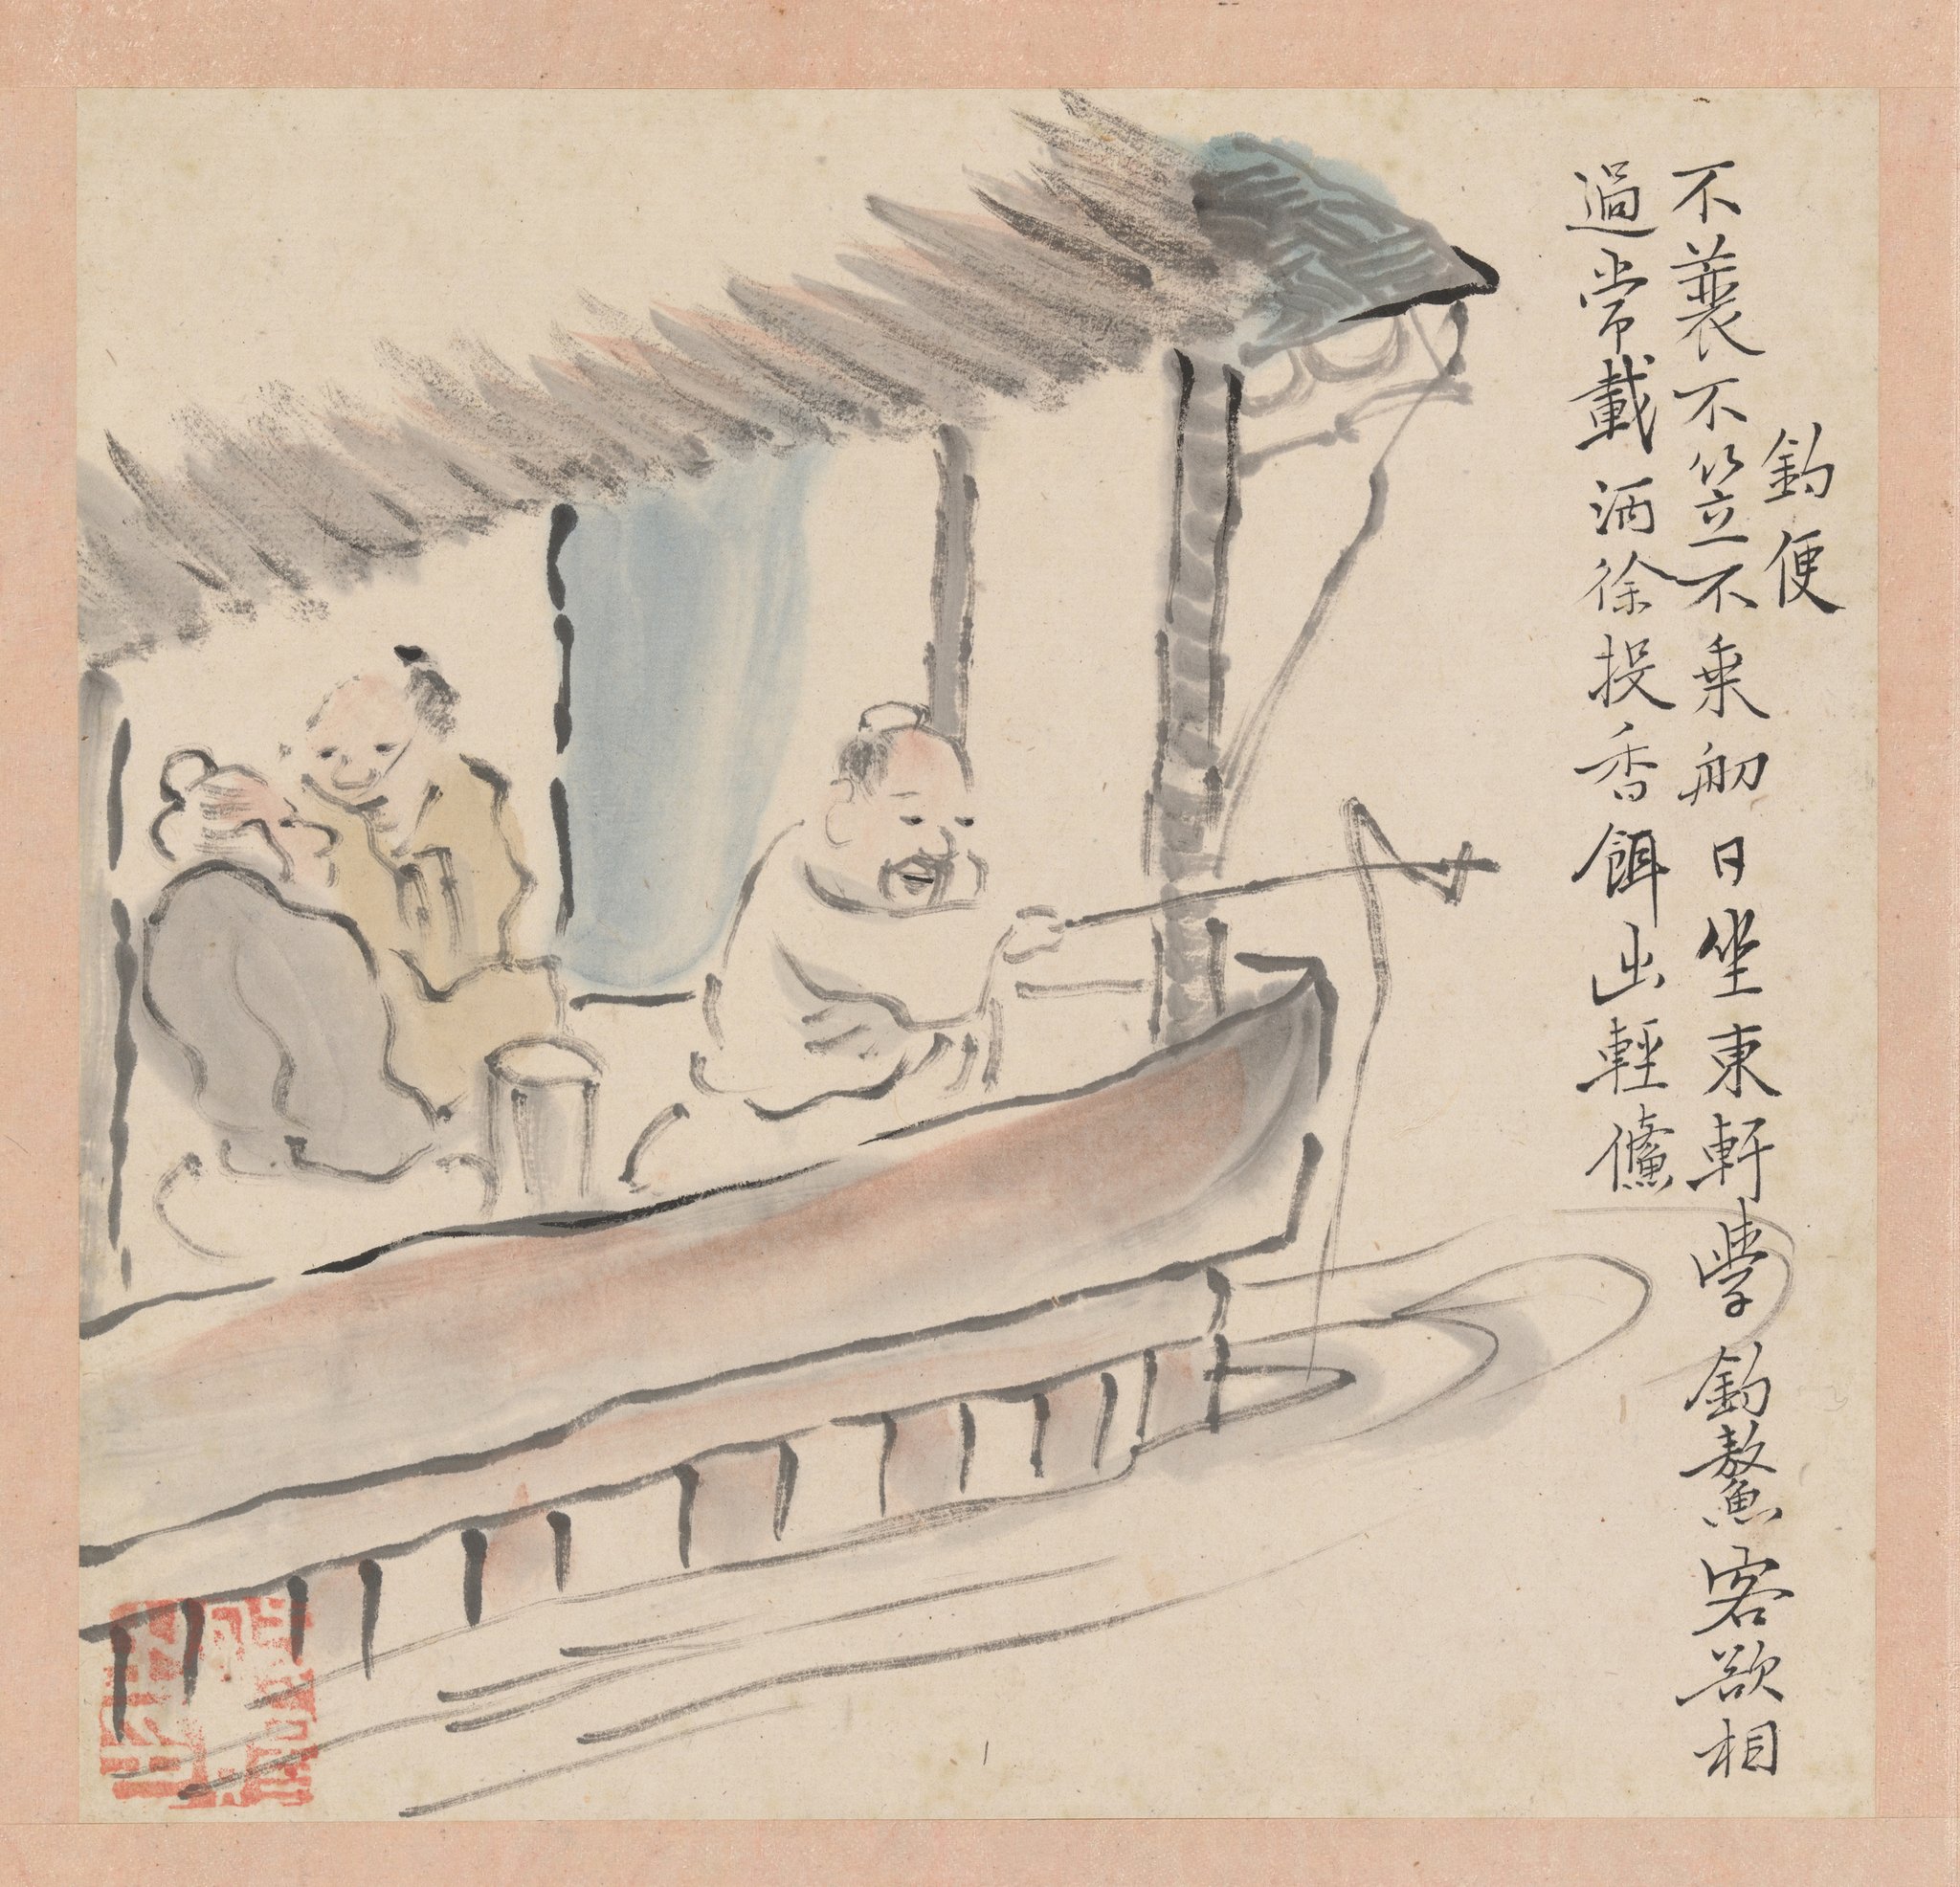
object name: album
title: After Ike no Taiga and Yosa Buson’s Ten Conveniences and Ten Pleasures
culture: japanese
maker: totoki baigai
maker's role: artist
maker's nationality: japanese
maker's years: 1749-1804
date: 1800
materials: ink, paper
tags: men,landscapes